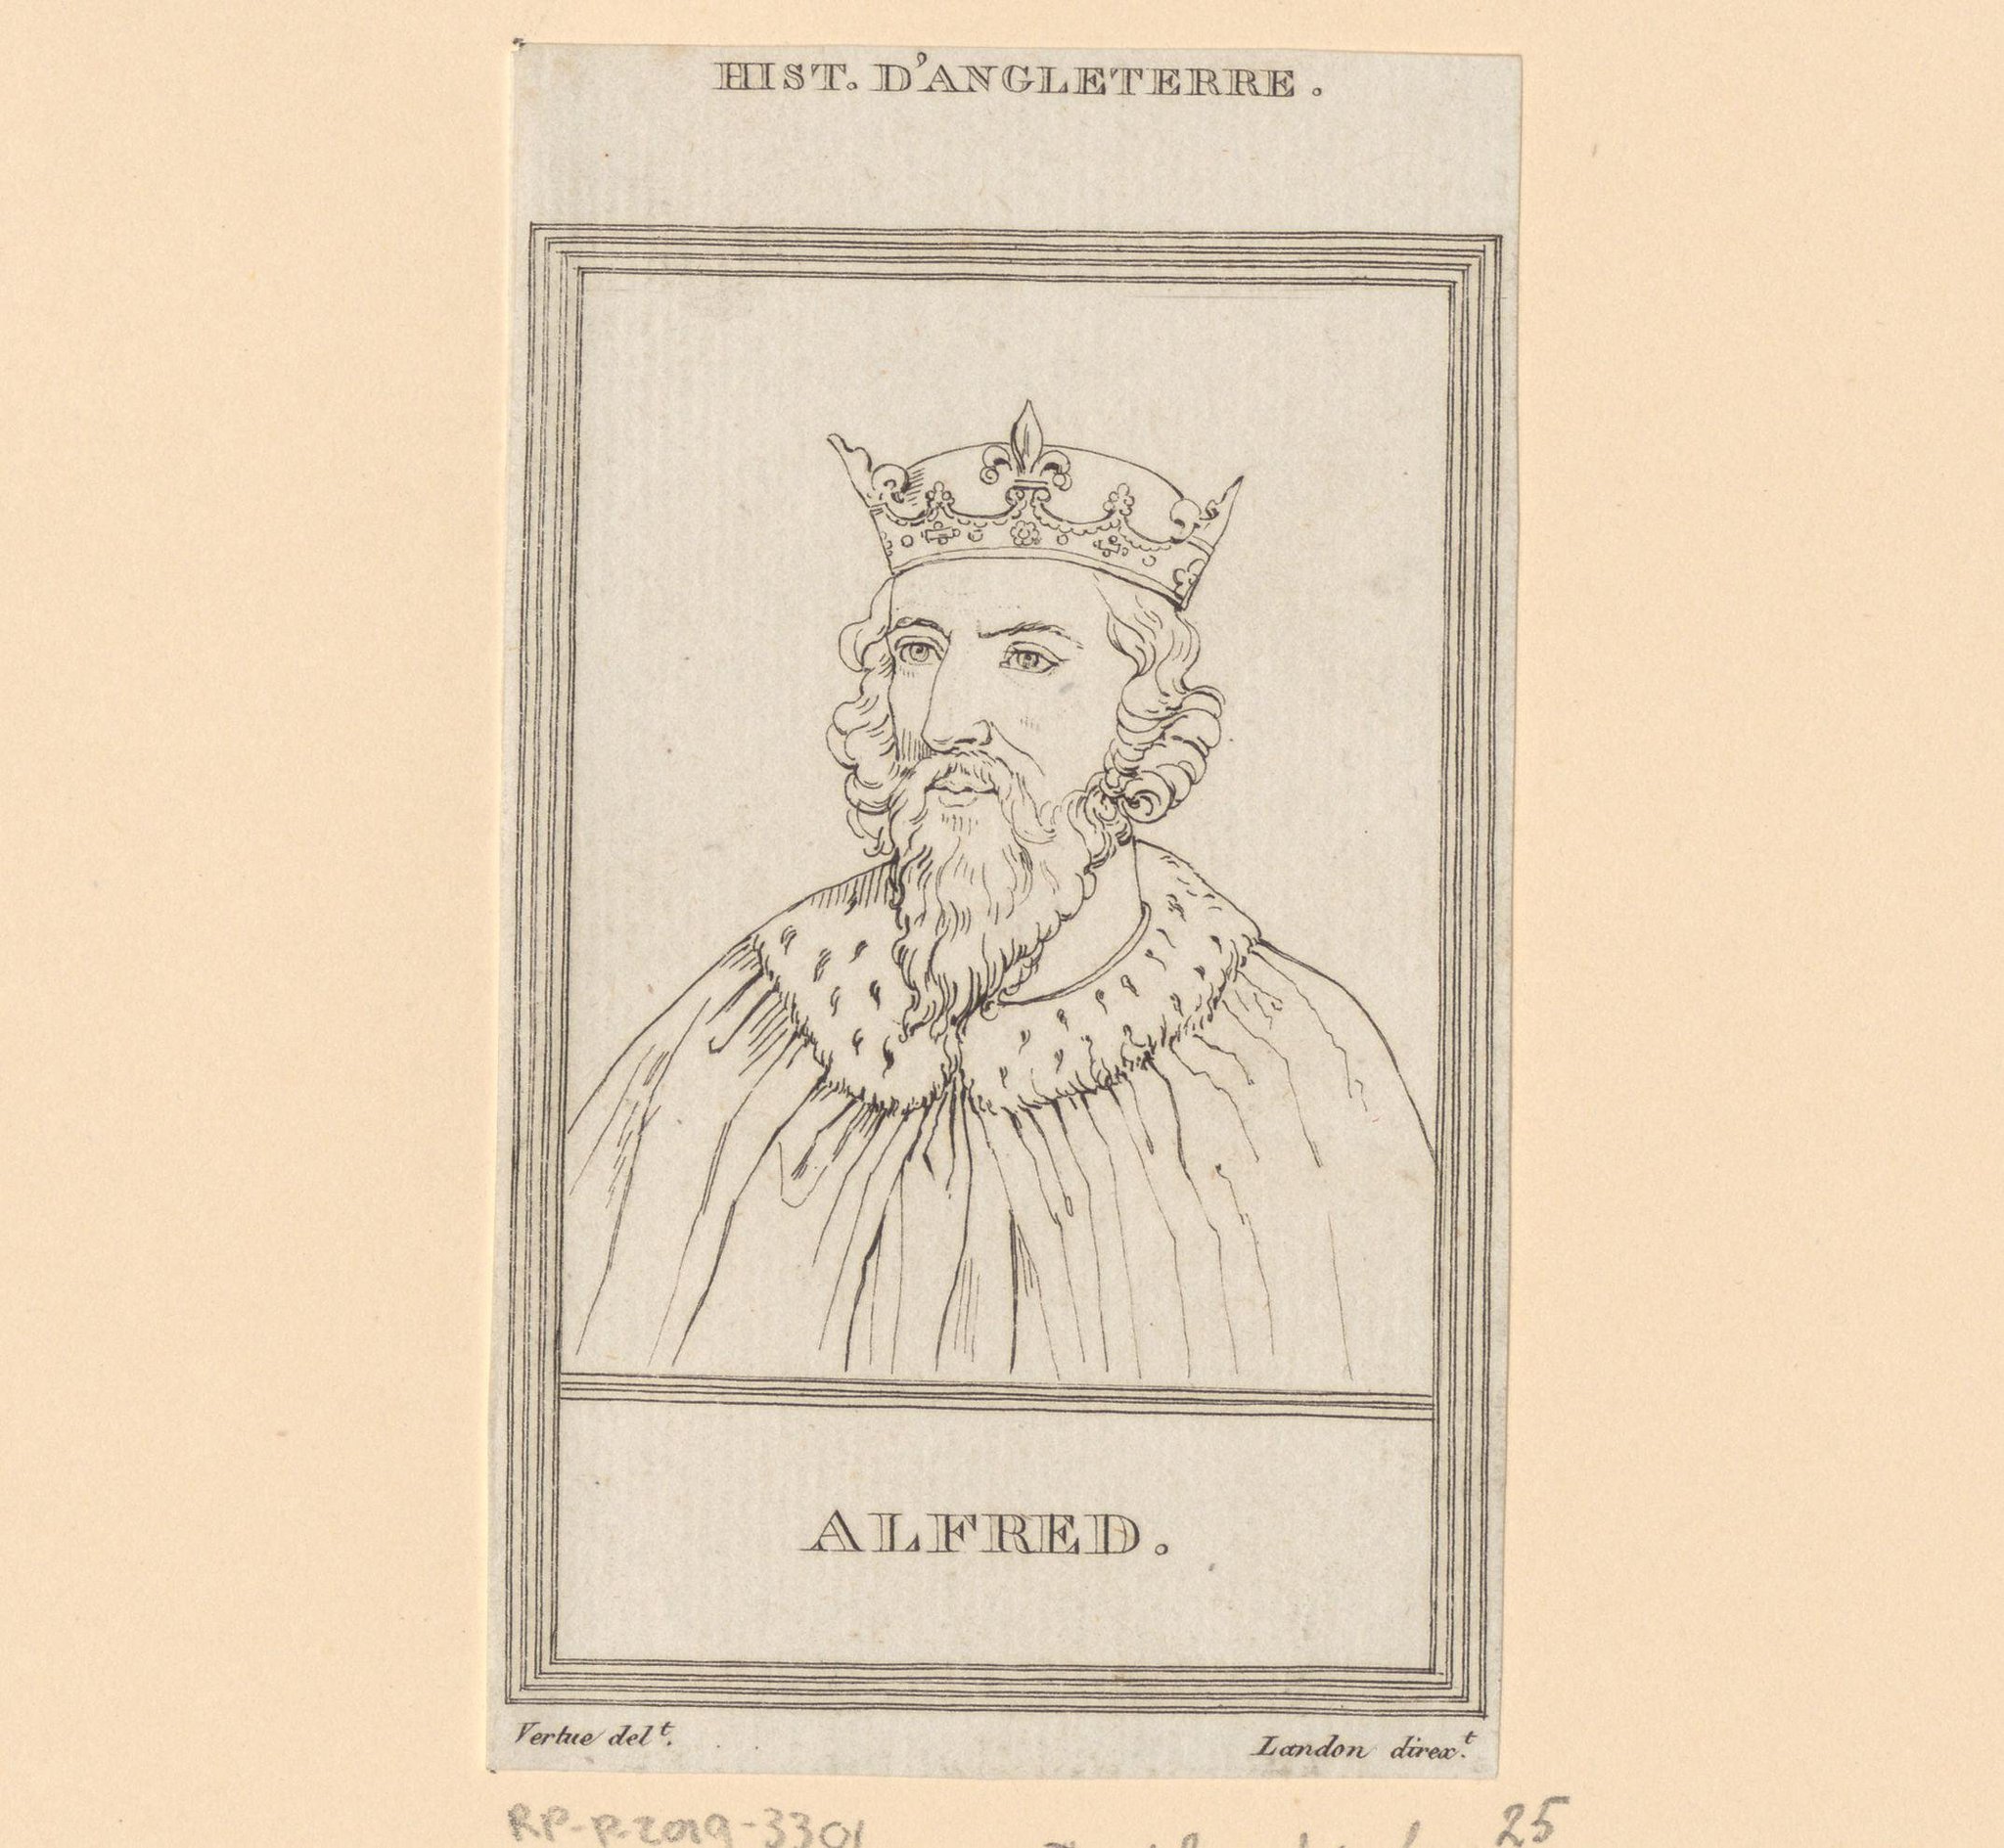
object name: print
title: Portret van koning Alfred de Grote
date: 1805-1811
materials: paper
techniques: etching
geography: théâtre des folies-marigny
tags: historical persons, ruler, sovereign, insignia and symbols of sovereignty (crown, diadem, sceptre, orb, seal, standard, cloak, pectoral)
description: Prent uit: Galerie historique des hommes les plus célèbres (...). Parijs: Charles Paul Landon, 1805-1811.